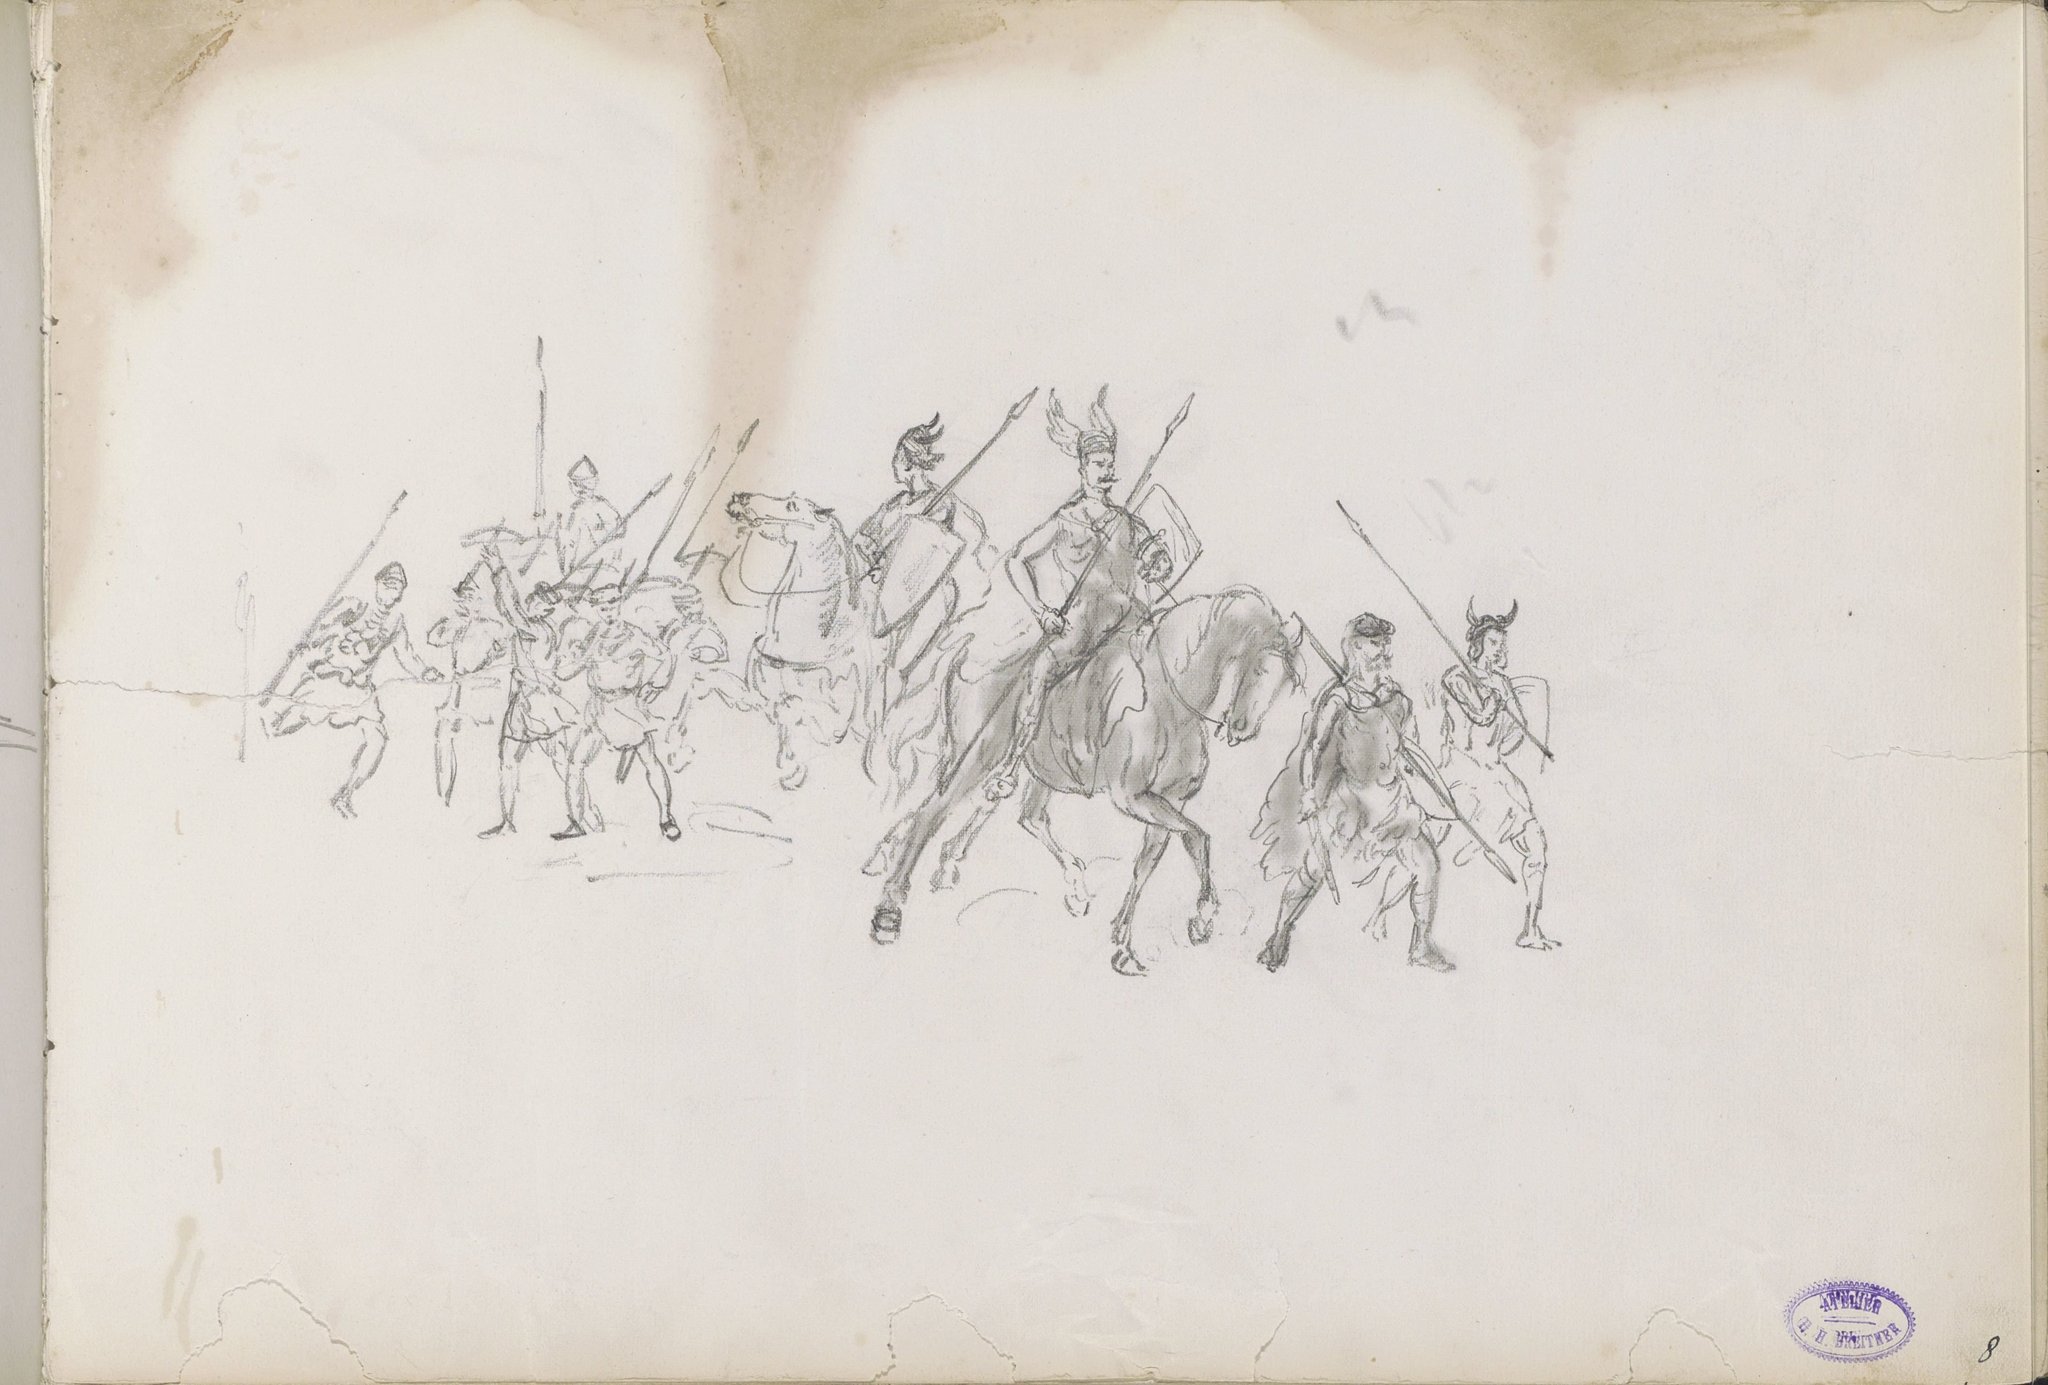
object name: sketchbook leaf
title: Soldaten met speren, te voet en te paard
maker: george hendrik breitner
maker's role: draughtsman, painter, print maker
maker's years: 1857-1923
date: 1873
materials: paper, pencil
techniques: stumping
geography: rotterdam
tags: division of armed forces (+ cavalry, horsemen), division of armed forces (+ infantry), casting weapons: spear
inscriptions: workshop stamp: Lugt 291d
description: Sommigen dragen een gevleugelde helm. Blad 8 recto uit een schetsboek met 25 bladen.